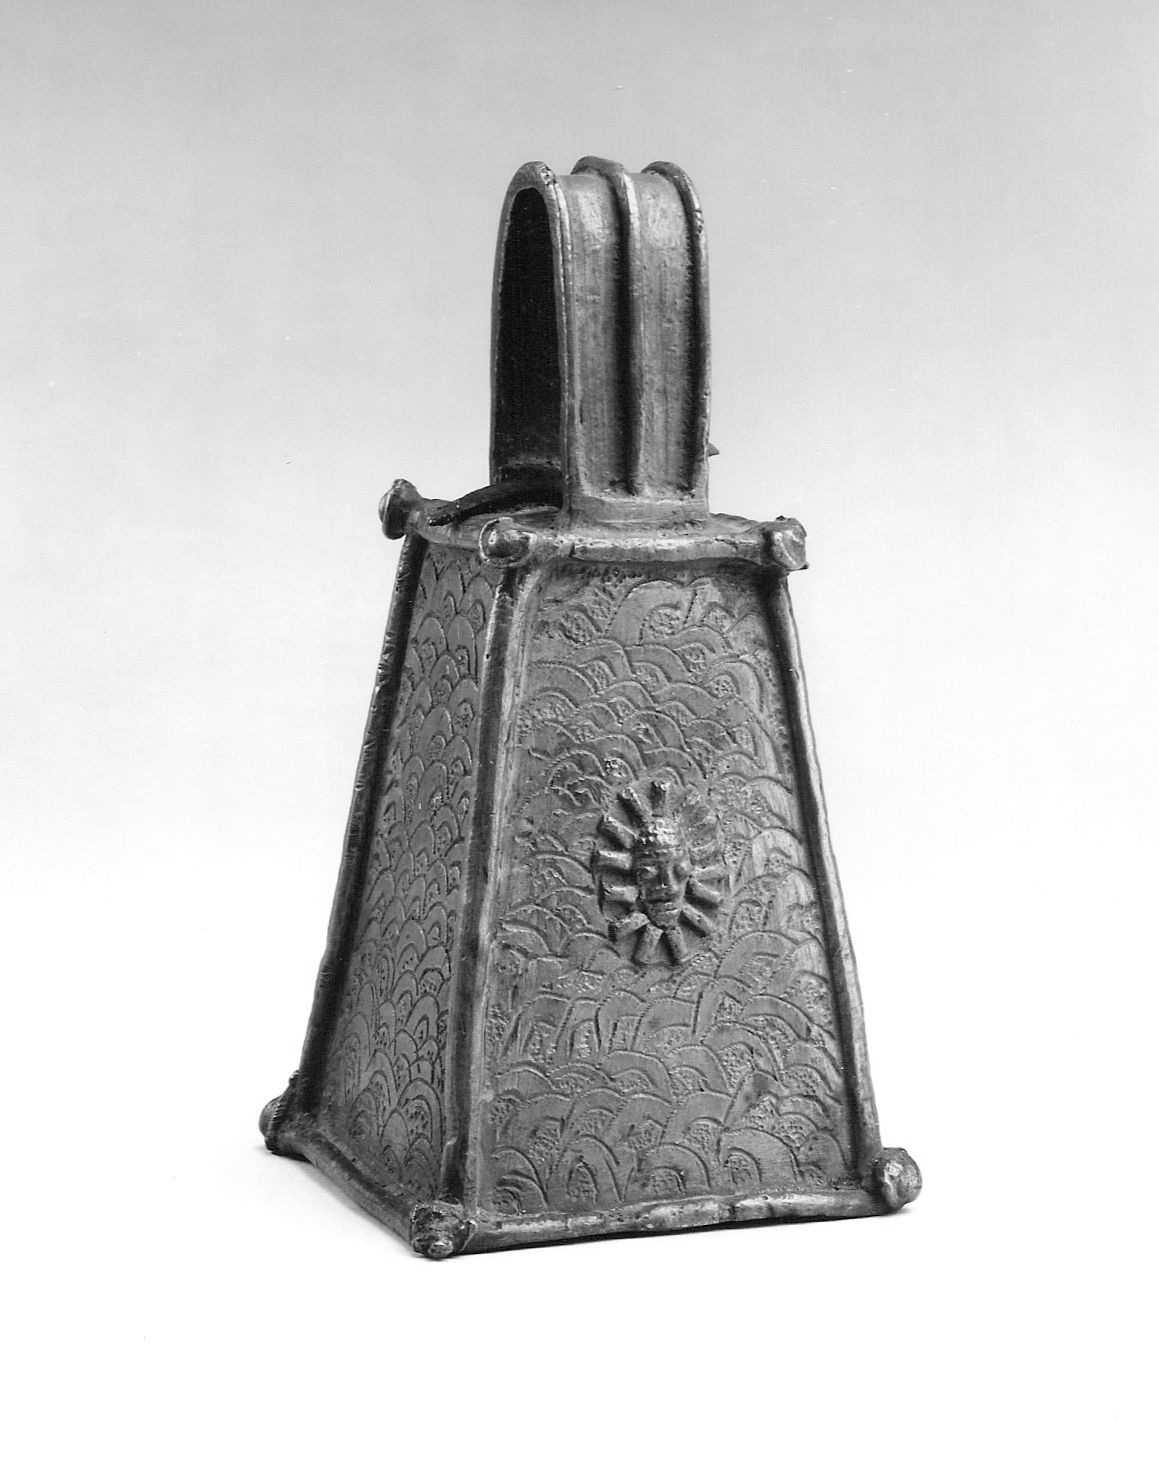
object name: bell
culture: benin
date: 1850-1889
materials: brass